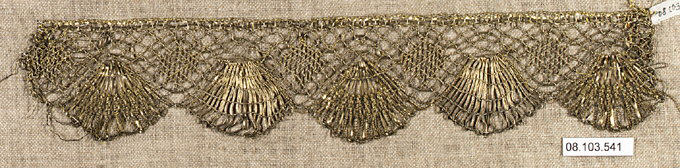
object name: piece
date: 1701-1900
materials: gold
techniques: lace